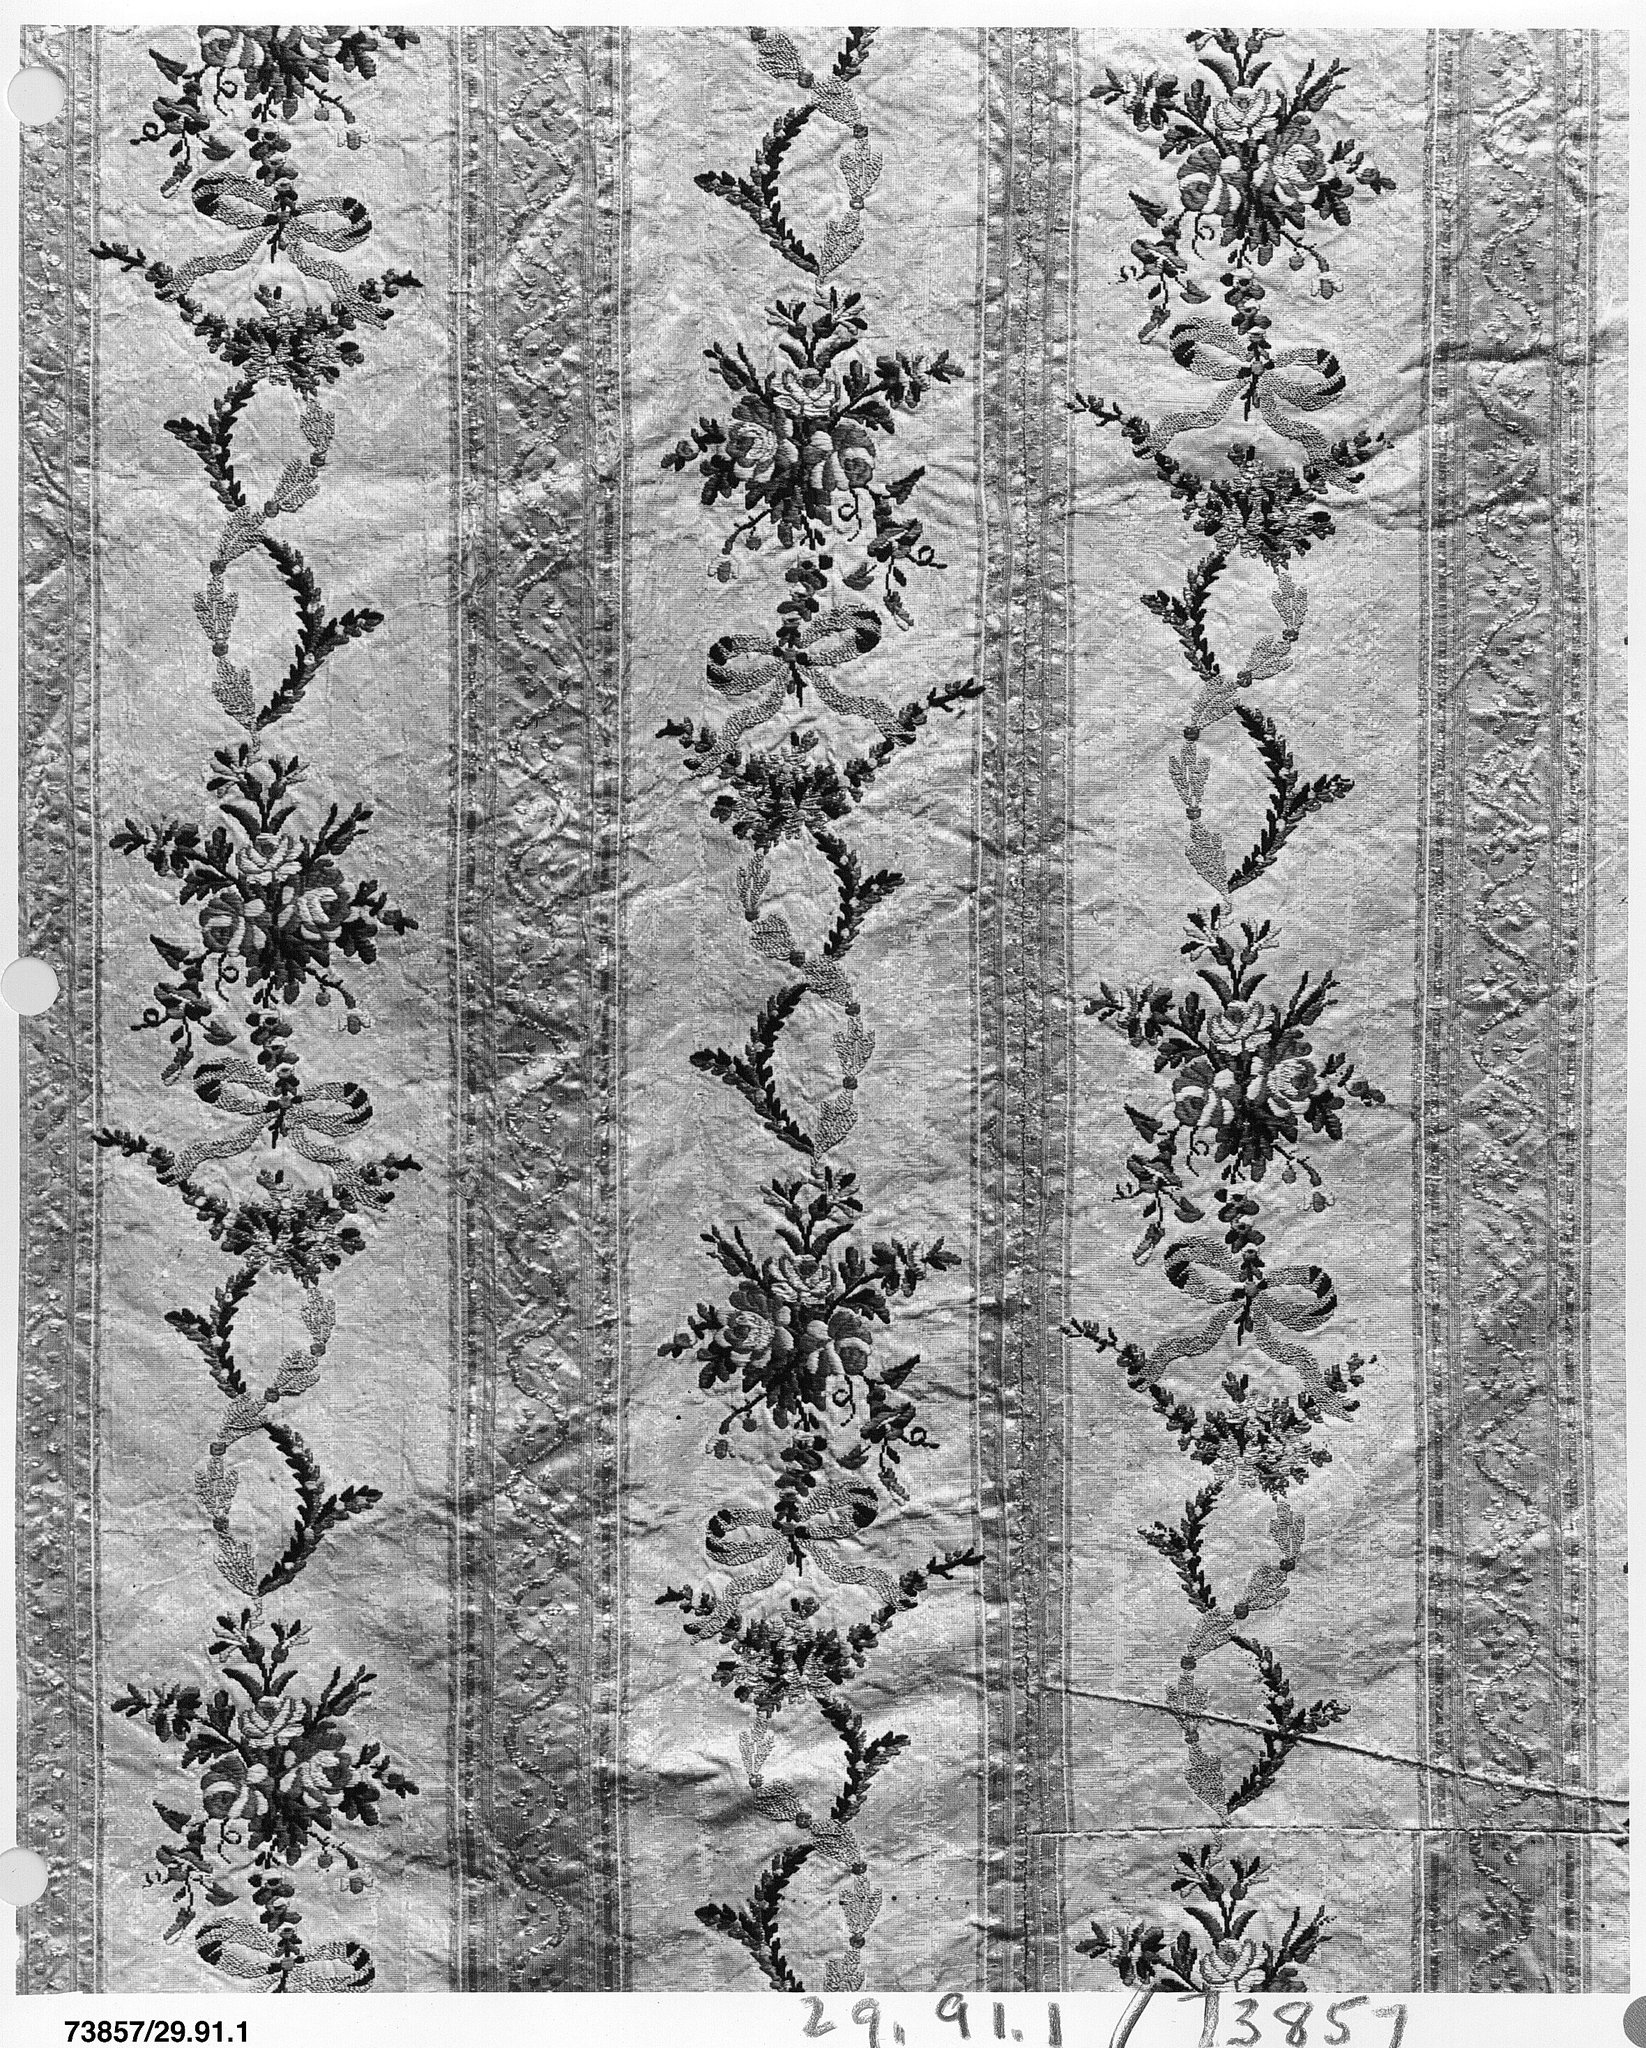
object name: piece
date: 1767-1800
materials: metal thread, silk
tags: flowers,leaves